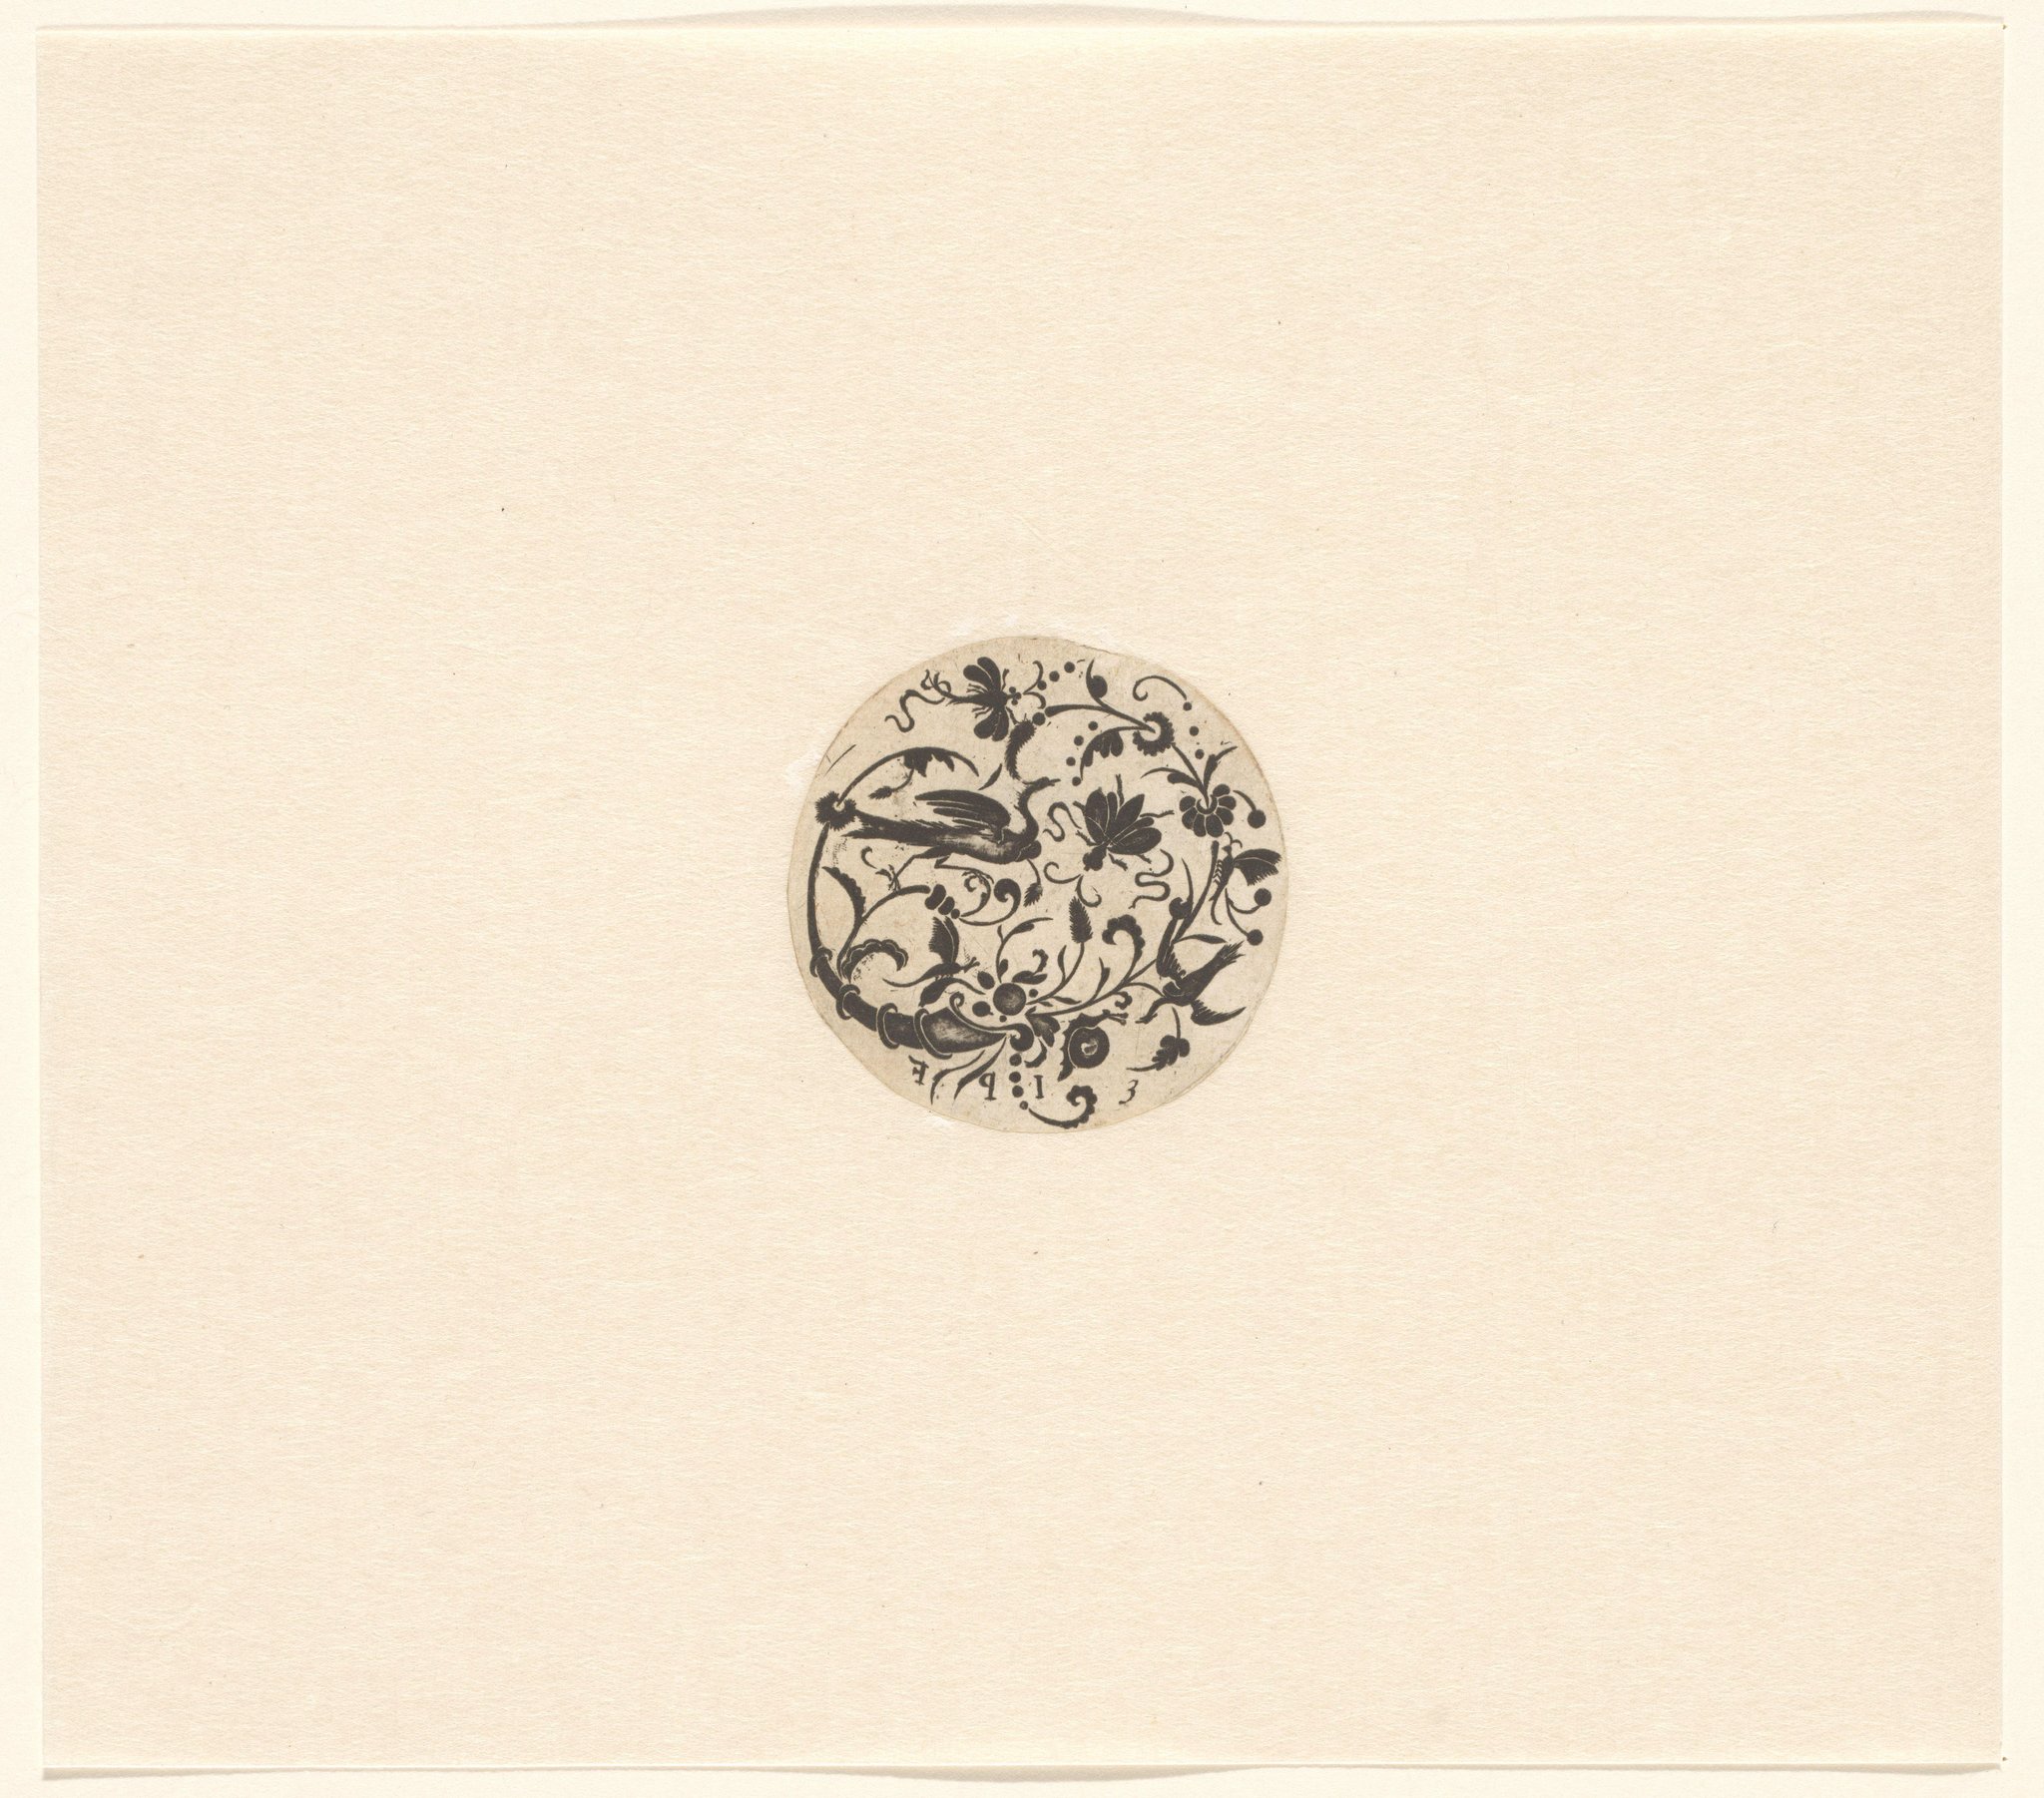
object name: ornament print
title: Ontwerp voor een deksel of hanger met vogels, insecten en florale motieven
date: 1625-1650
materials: niello, paper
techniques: etching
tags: 'cornucopia', horn of plenty, birds, other ornament derived from animal forms, insects, ornament derived from plant forms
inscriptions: collector's mark: Lugt 2228, collector's mark: Lugt 2760